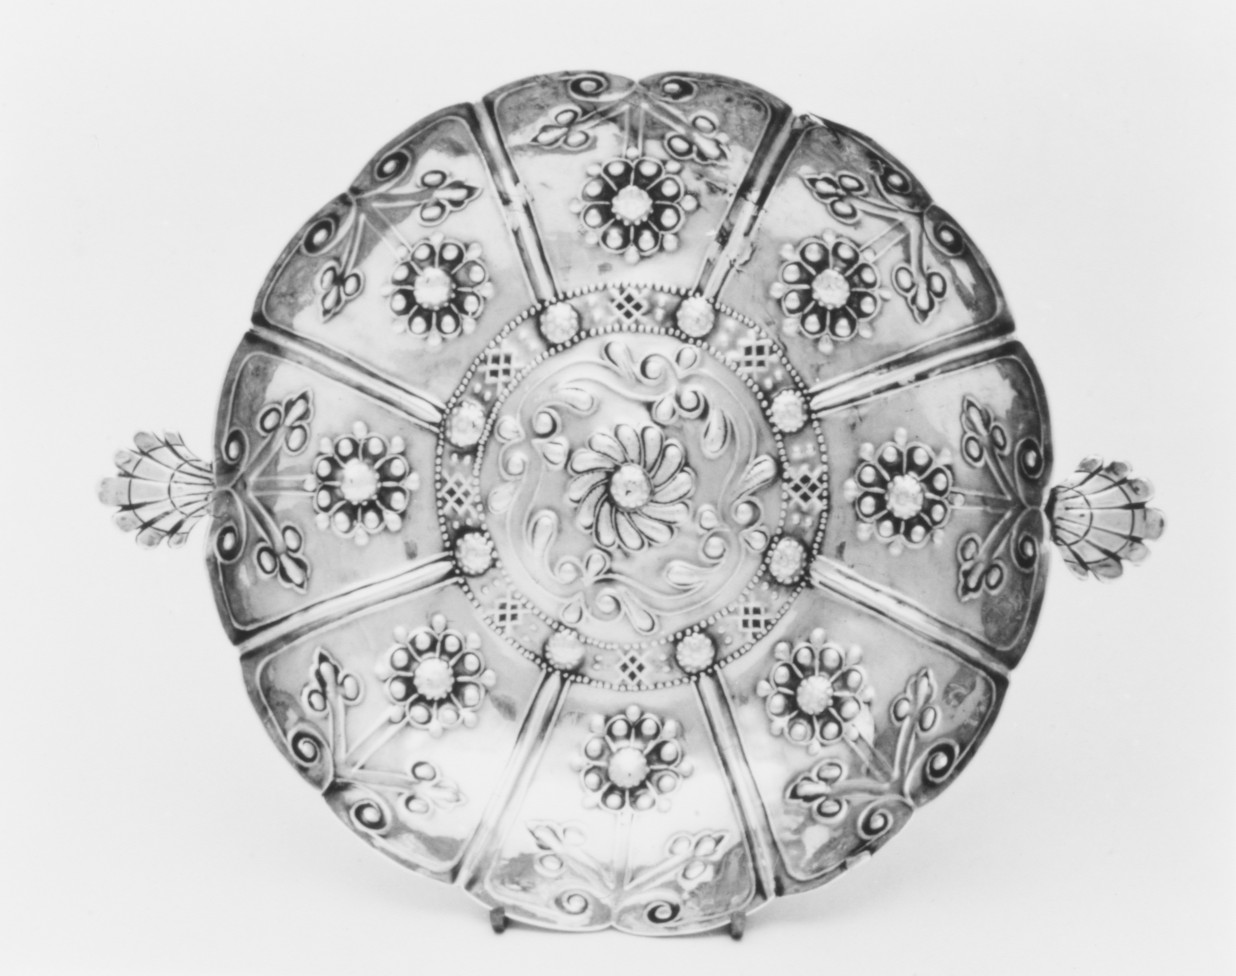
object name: dish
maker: william maunday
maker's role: maker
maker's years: 1575-1675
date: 1631-1632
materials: silver gilt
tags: flowers